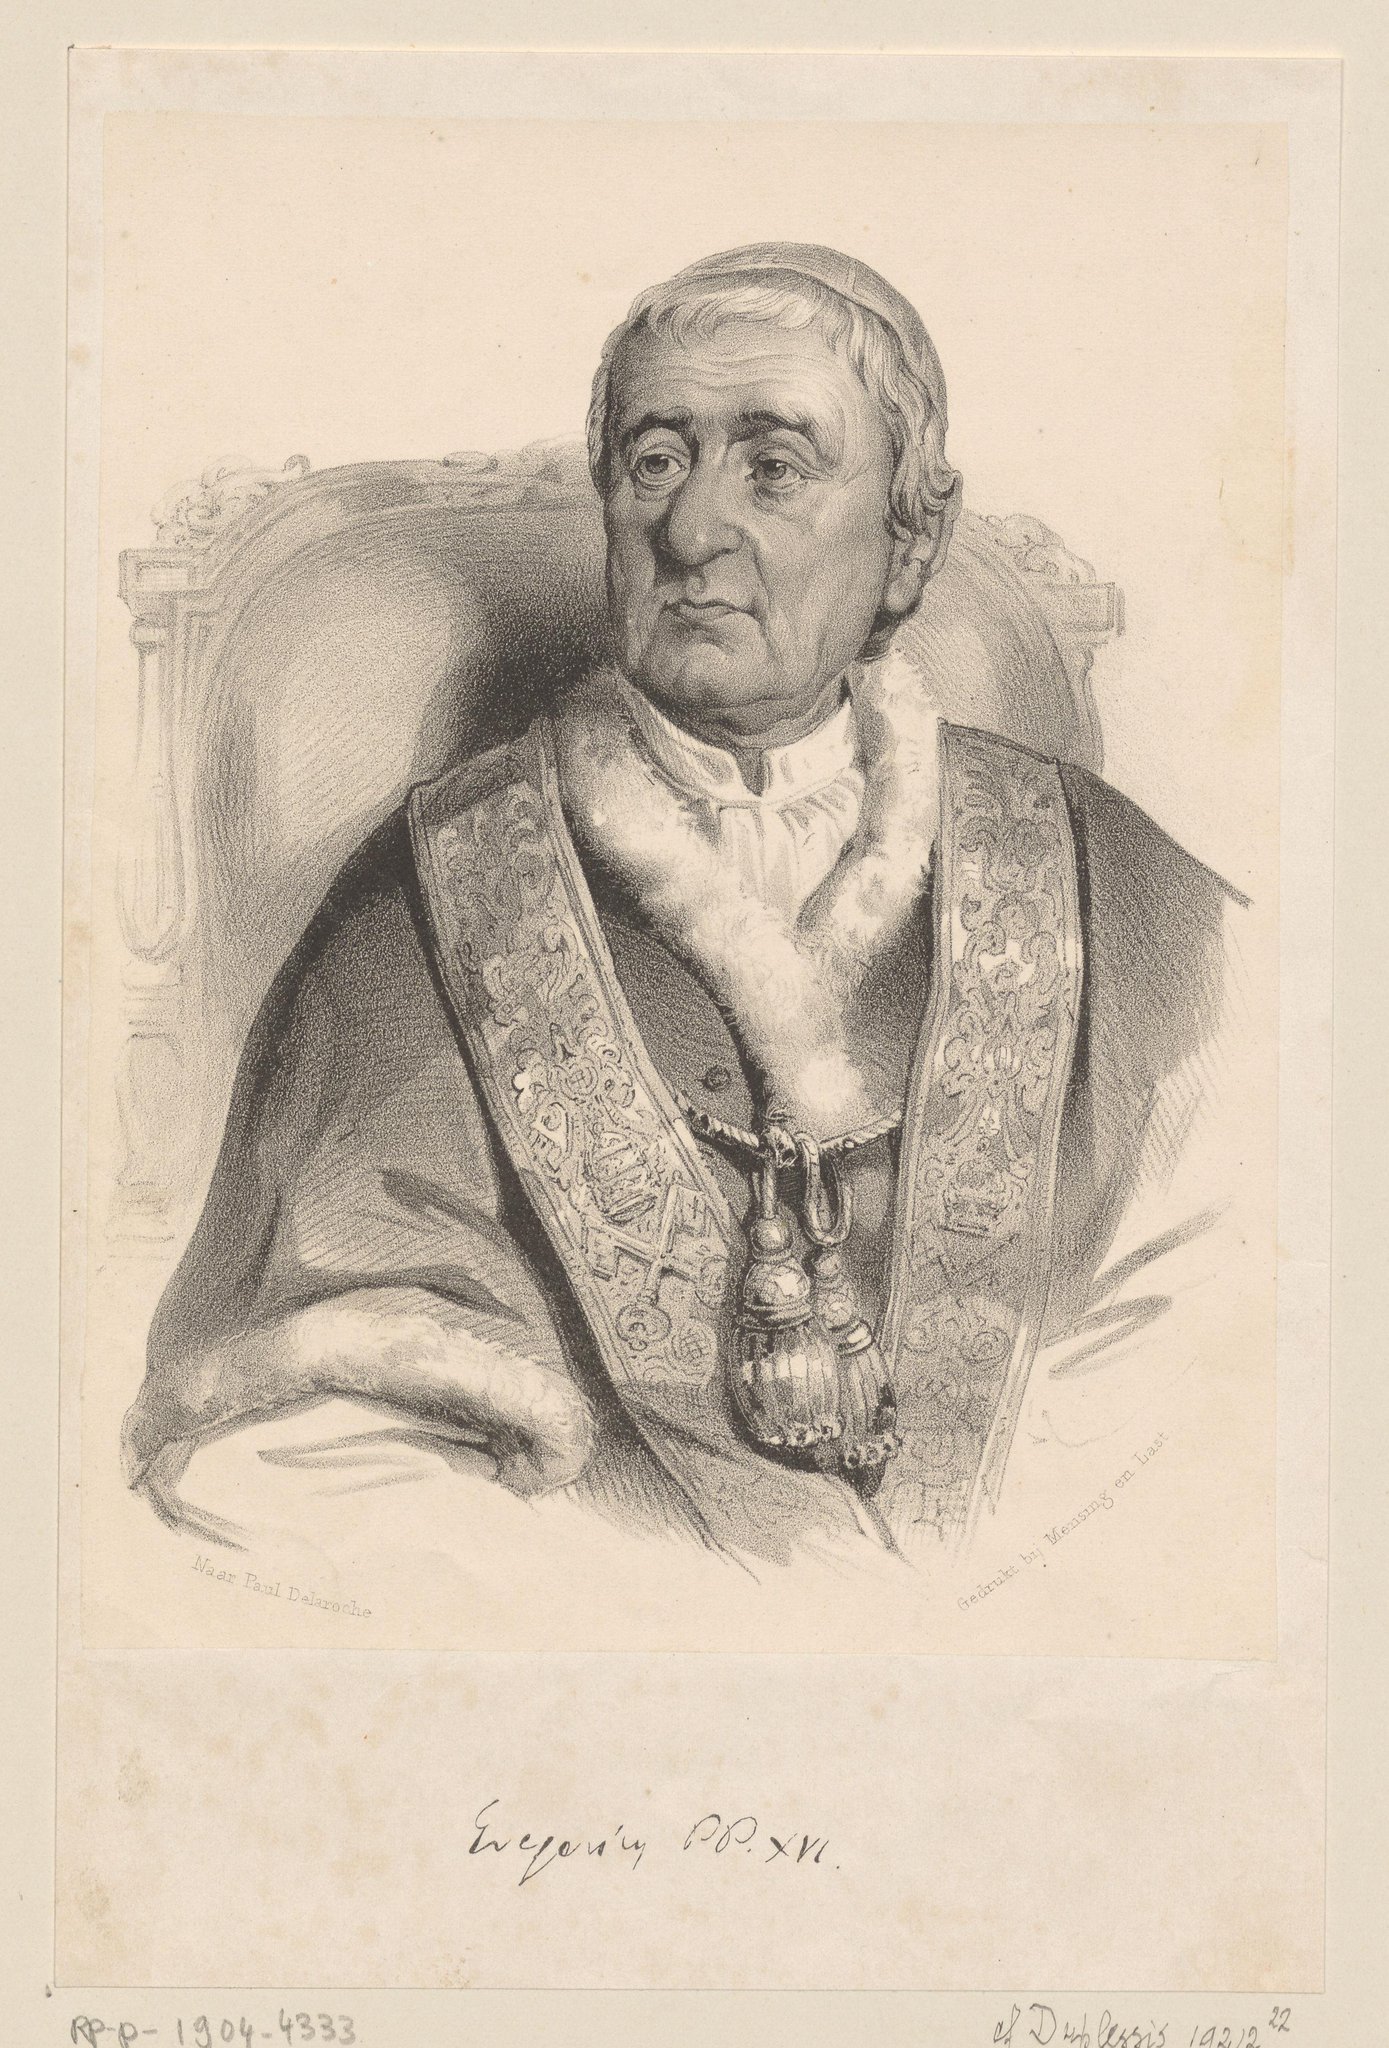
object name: print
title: Portret van paus Gregorius XVI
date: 1846-1847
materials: paper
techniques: lithograph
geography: the hague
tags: rome, historical persons, pope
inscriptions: collector's mark: Lugt 2228